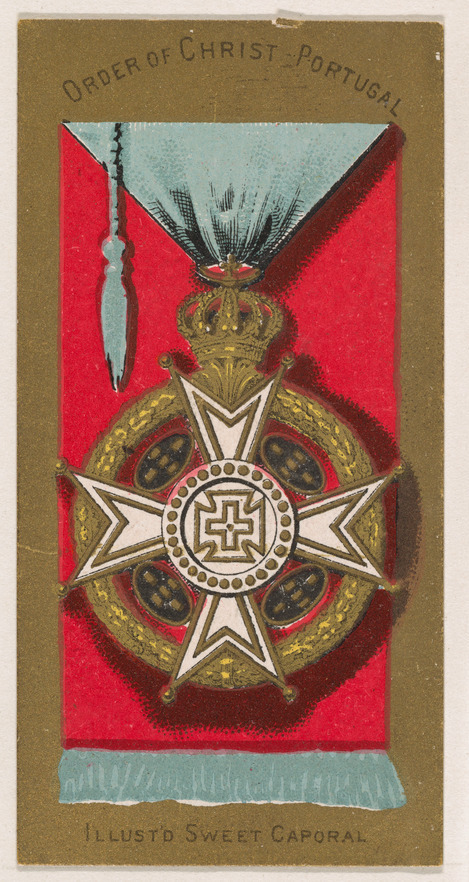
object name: print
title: Order of Christ, Portugal, from the Military Series (N224) issued by Kinney Tobacco Company to promote Sweet Caporal Cigarettes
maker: kinney brothers tobacco company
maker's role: publisher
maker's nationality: american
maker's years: 1869-2011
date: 1888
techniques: color lithograph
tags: cross,insignia